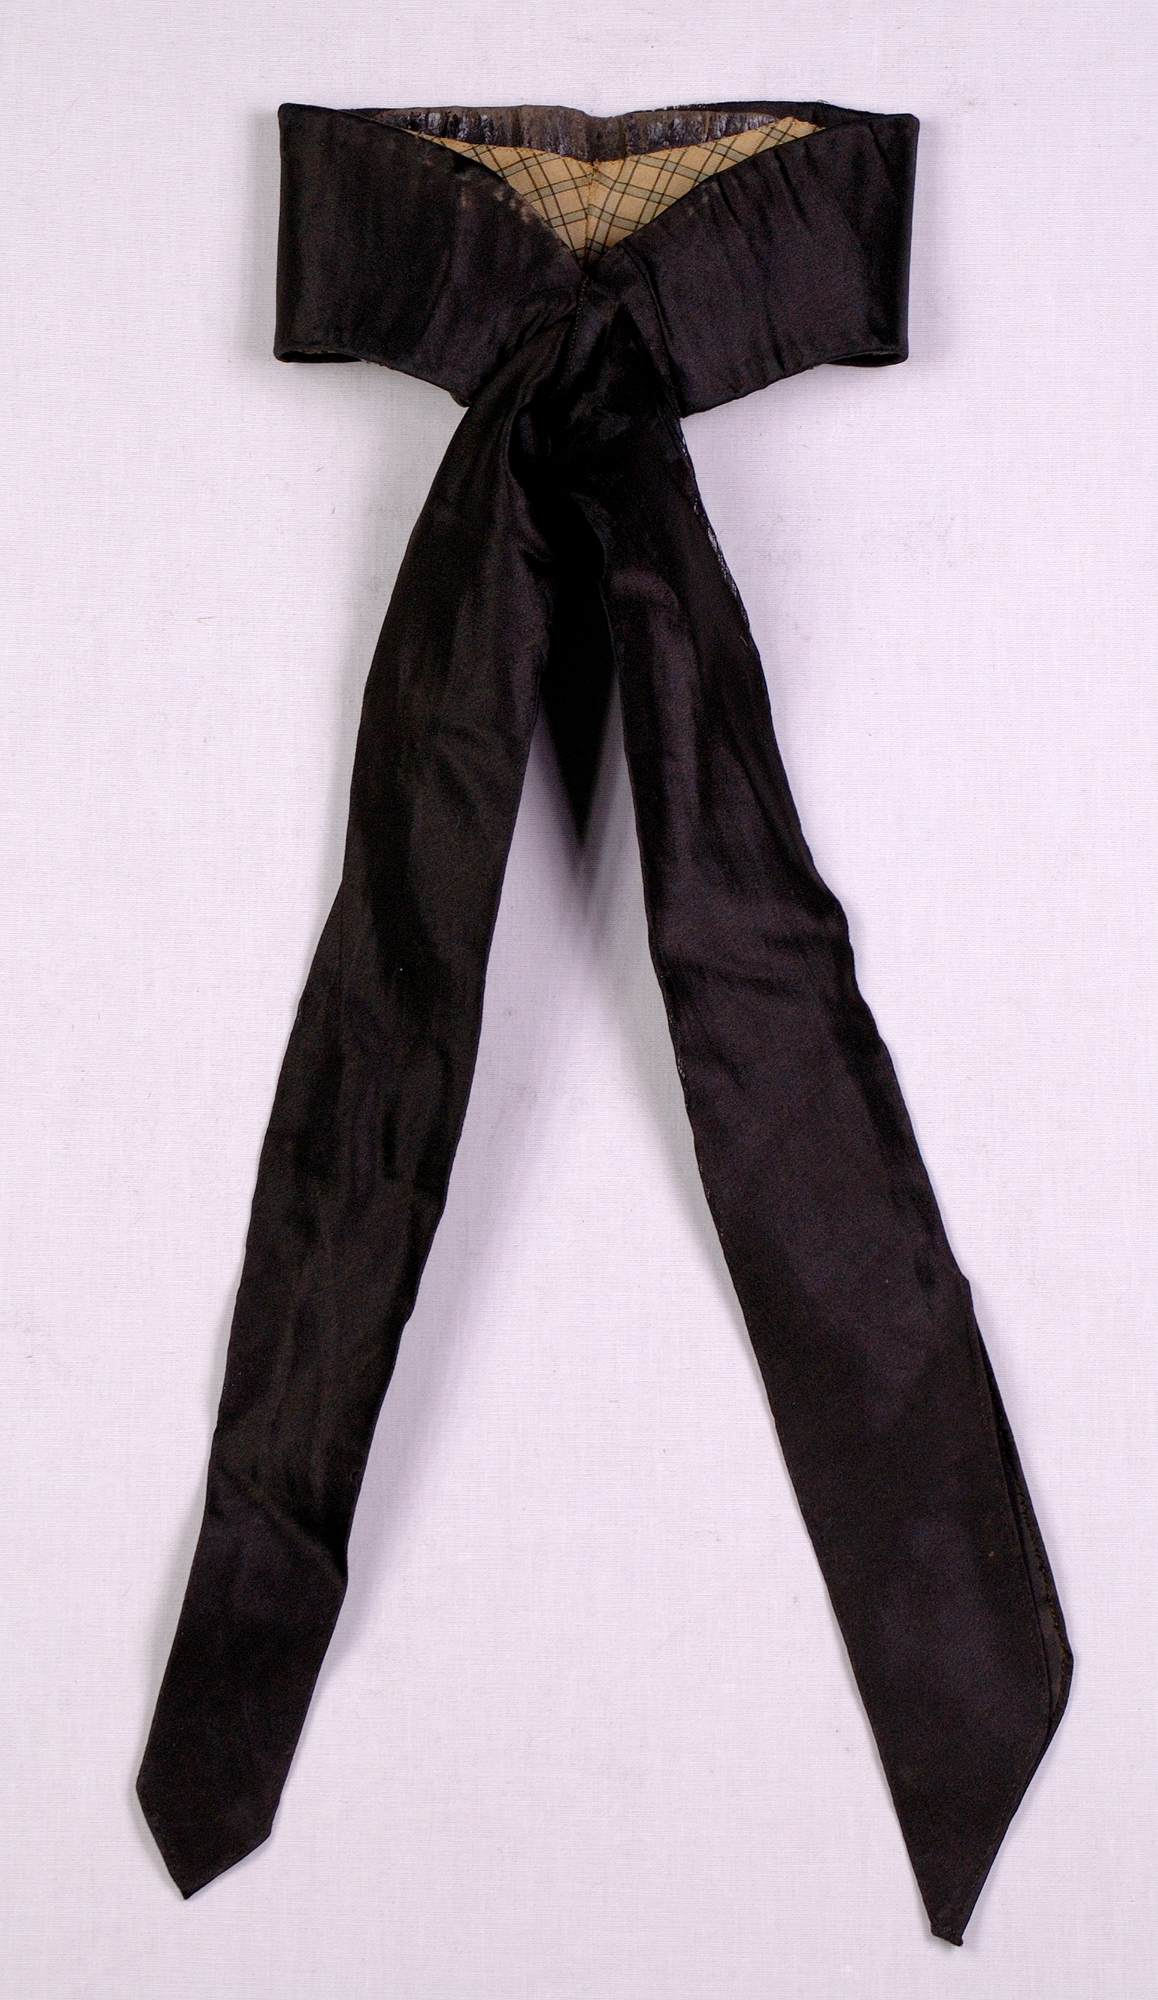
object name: stock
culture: american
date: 1830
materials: leather, metal, silk